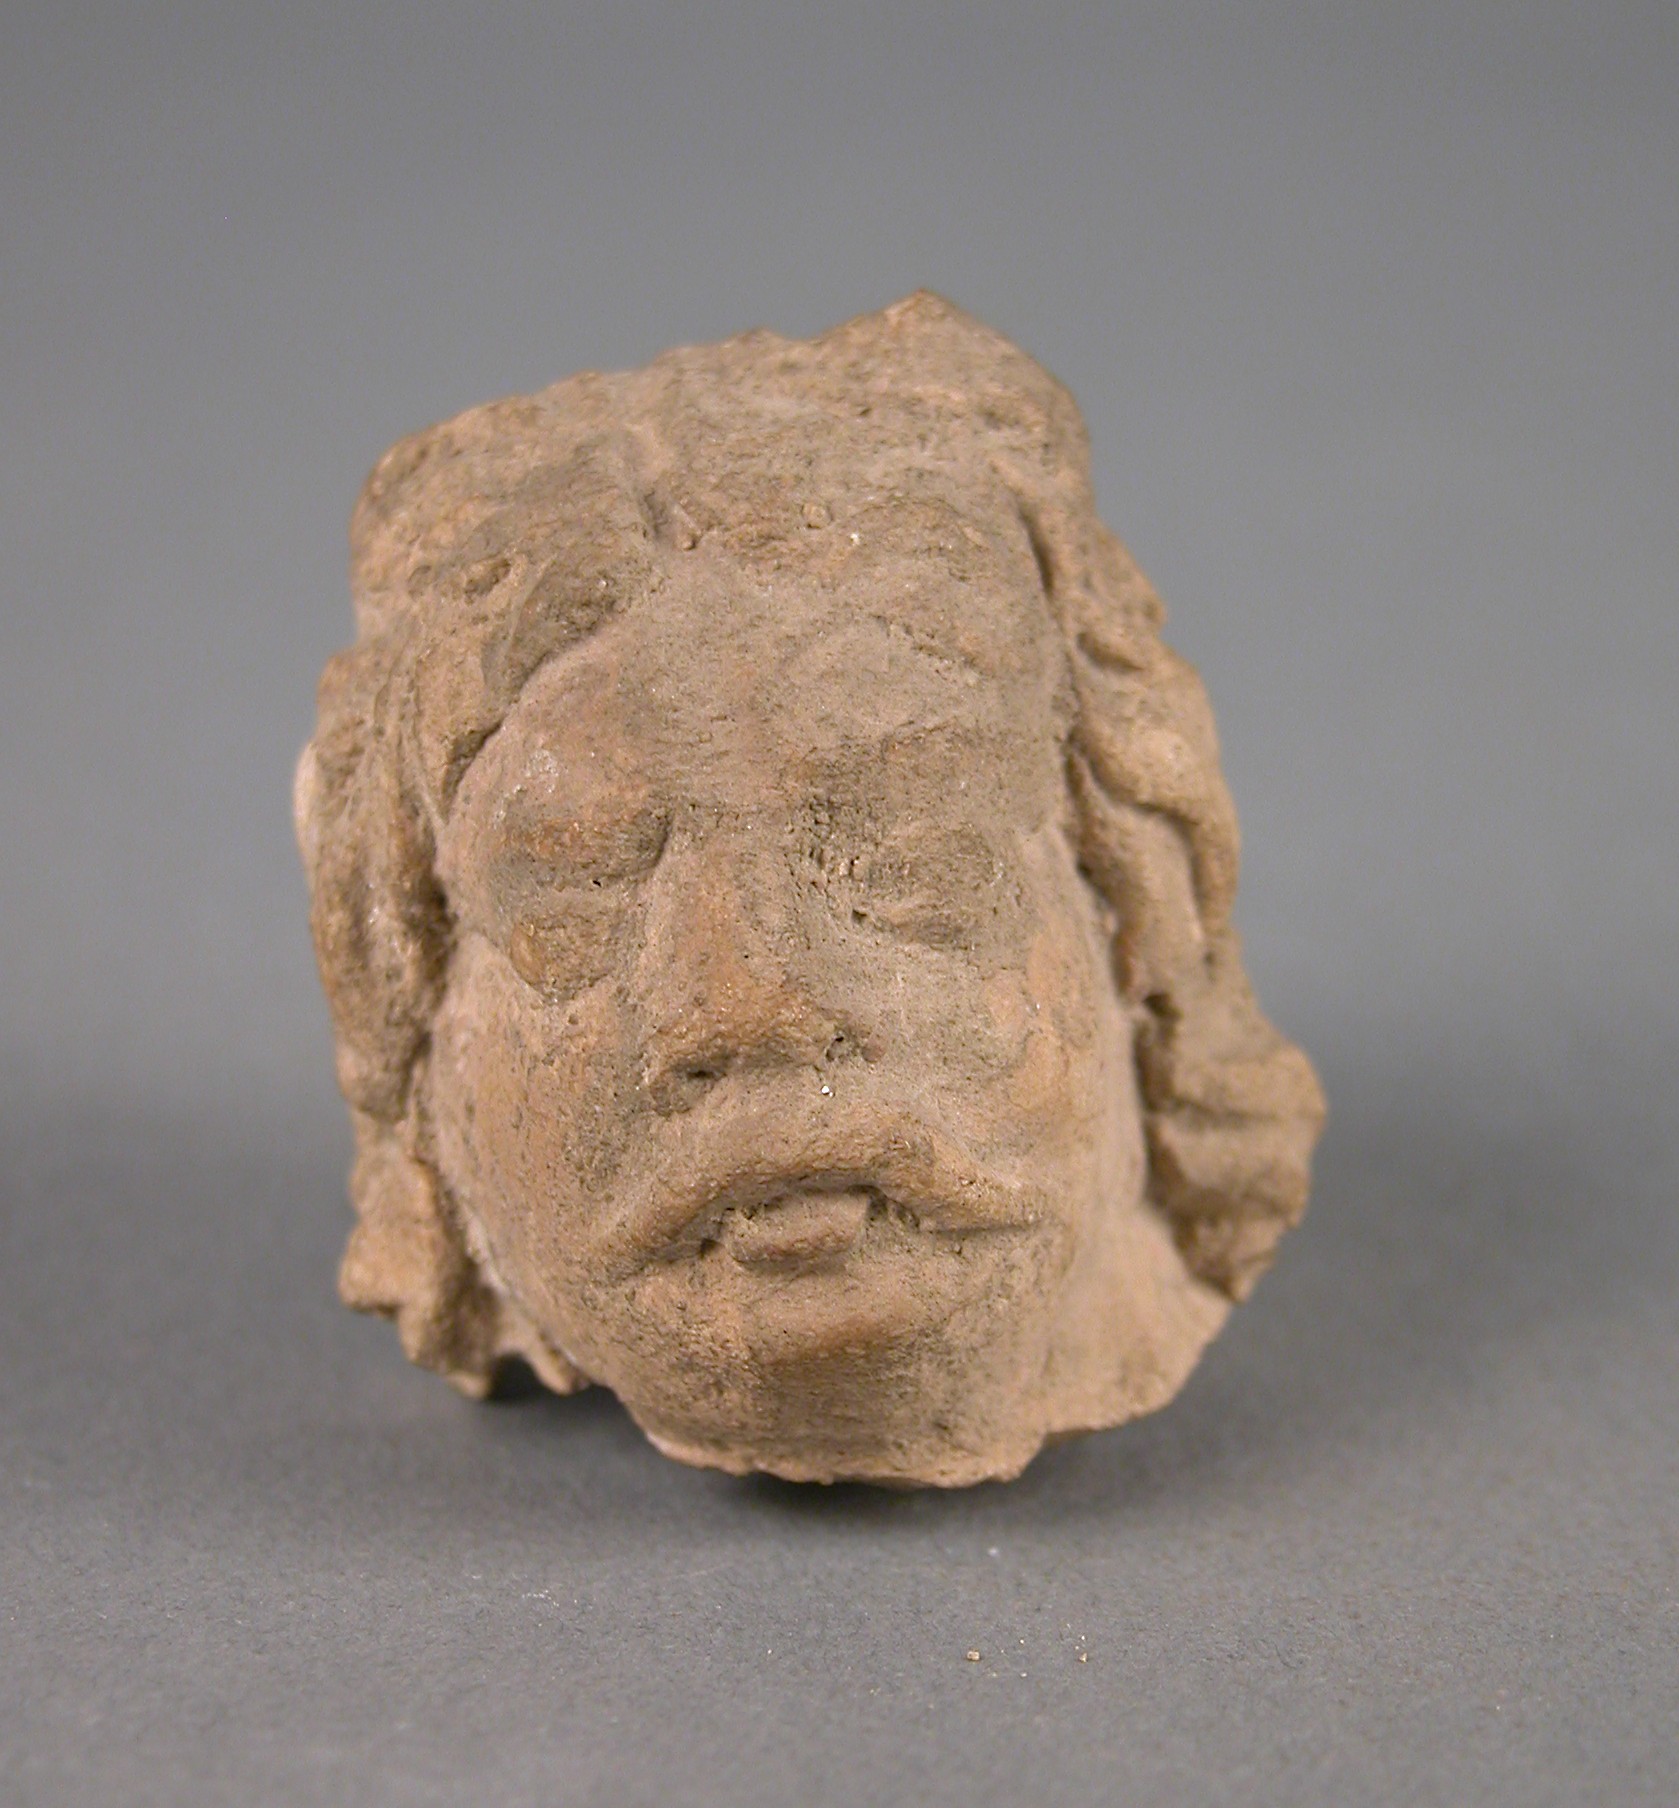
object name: wall decoration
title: Head of an Iranian Nomad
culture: gandhara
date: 301-400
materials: plaster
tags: gandhara,heads